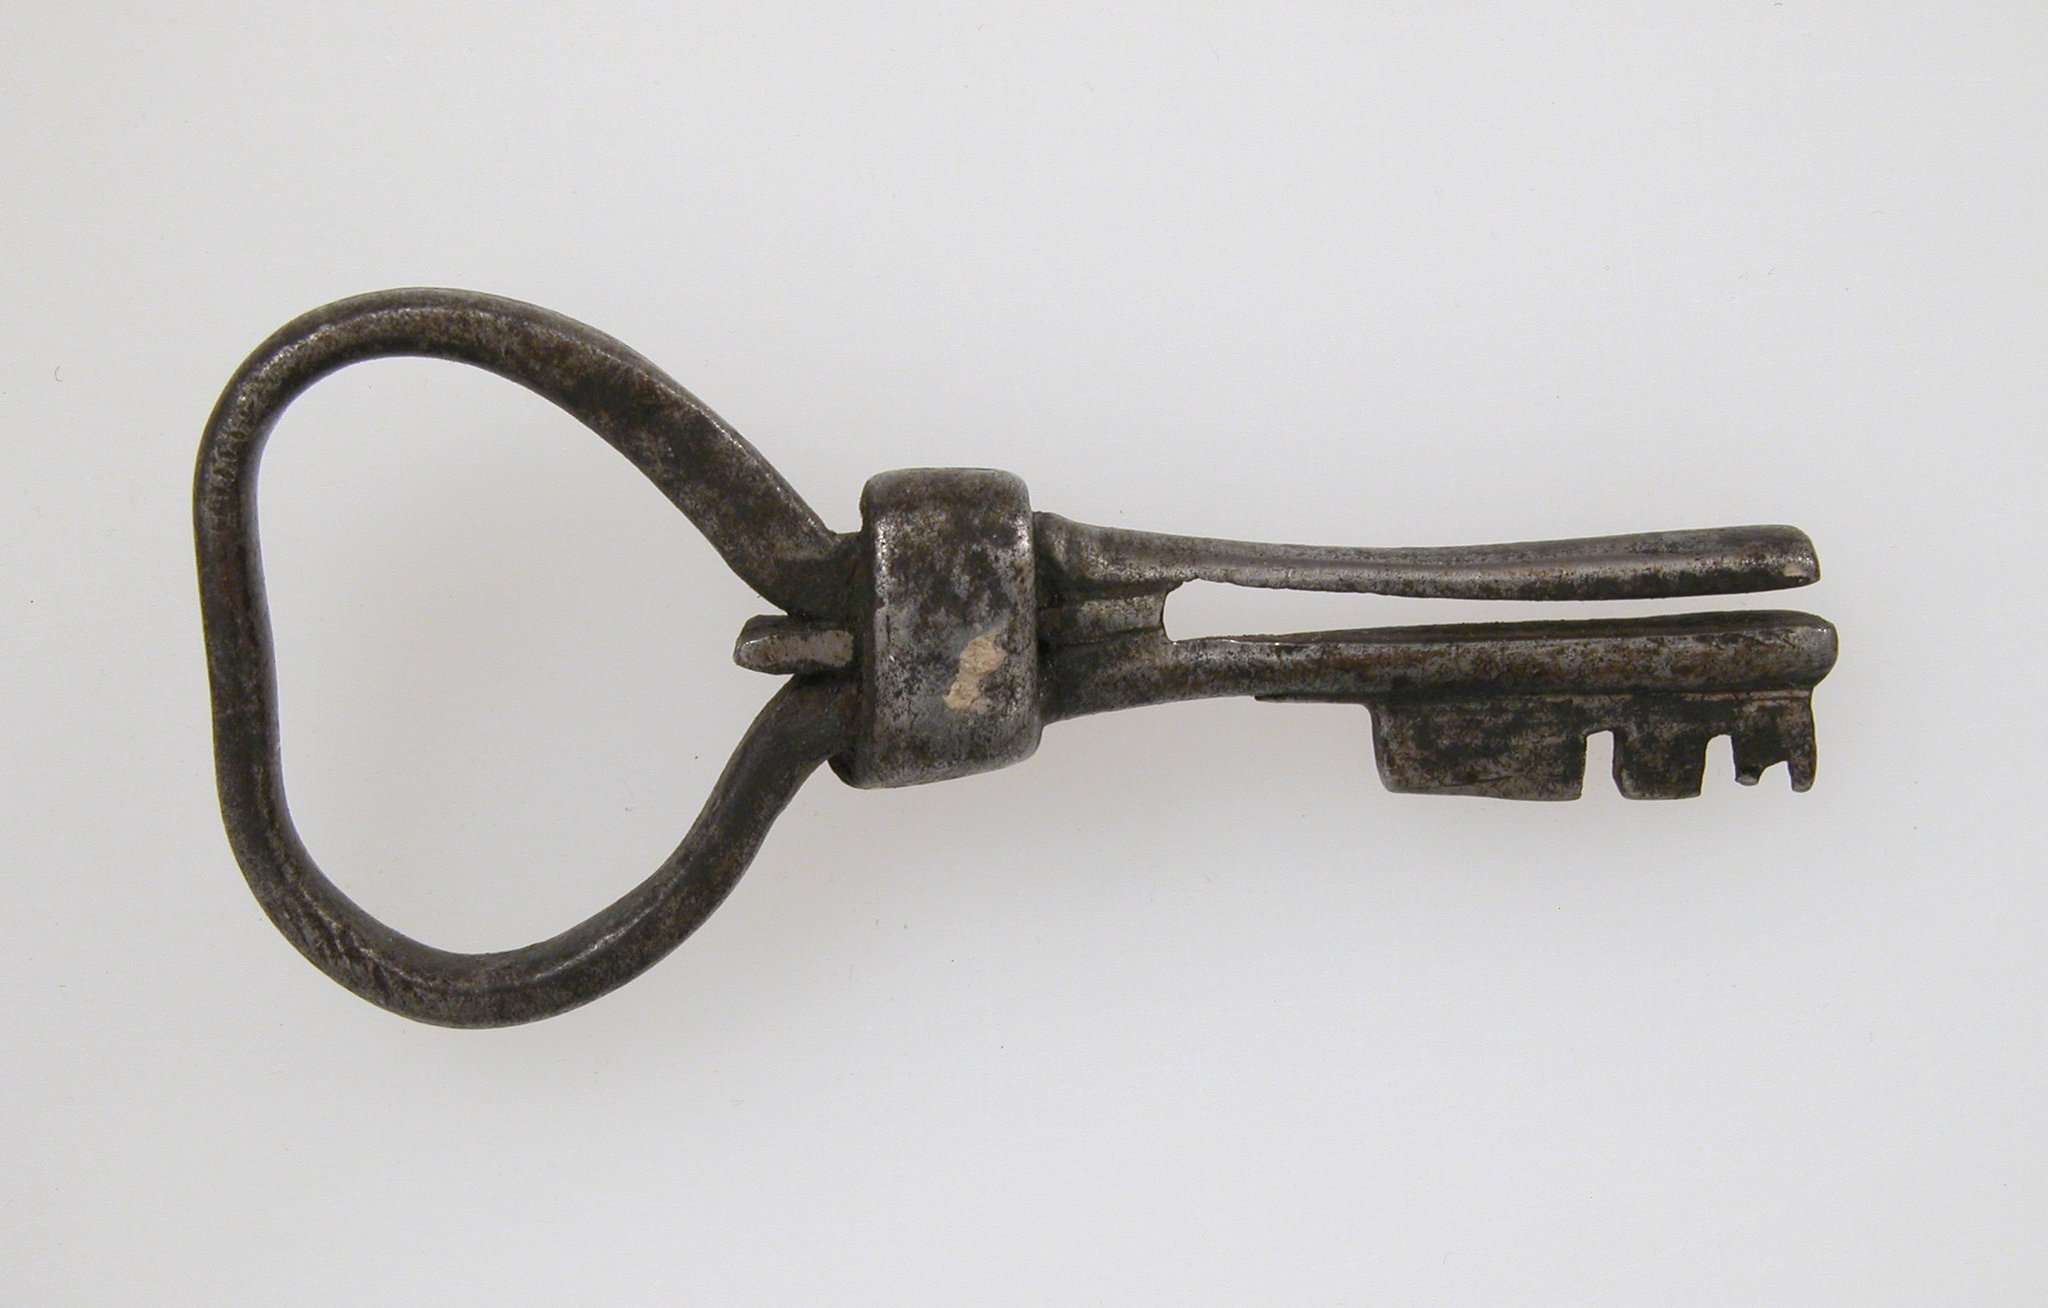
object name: key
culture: german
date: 1301-1400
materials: iron